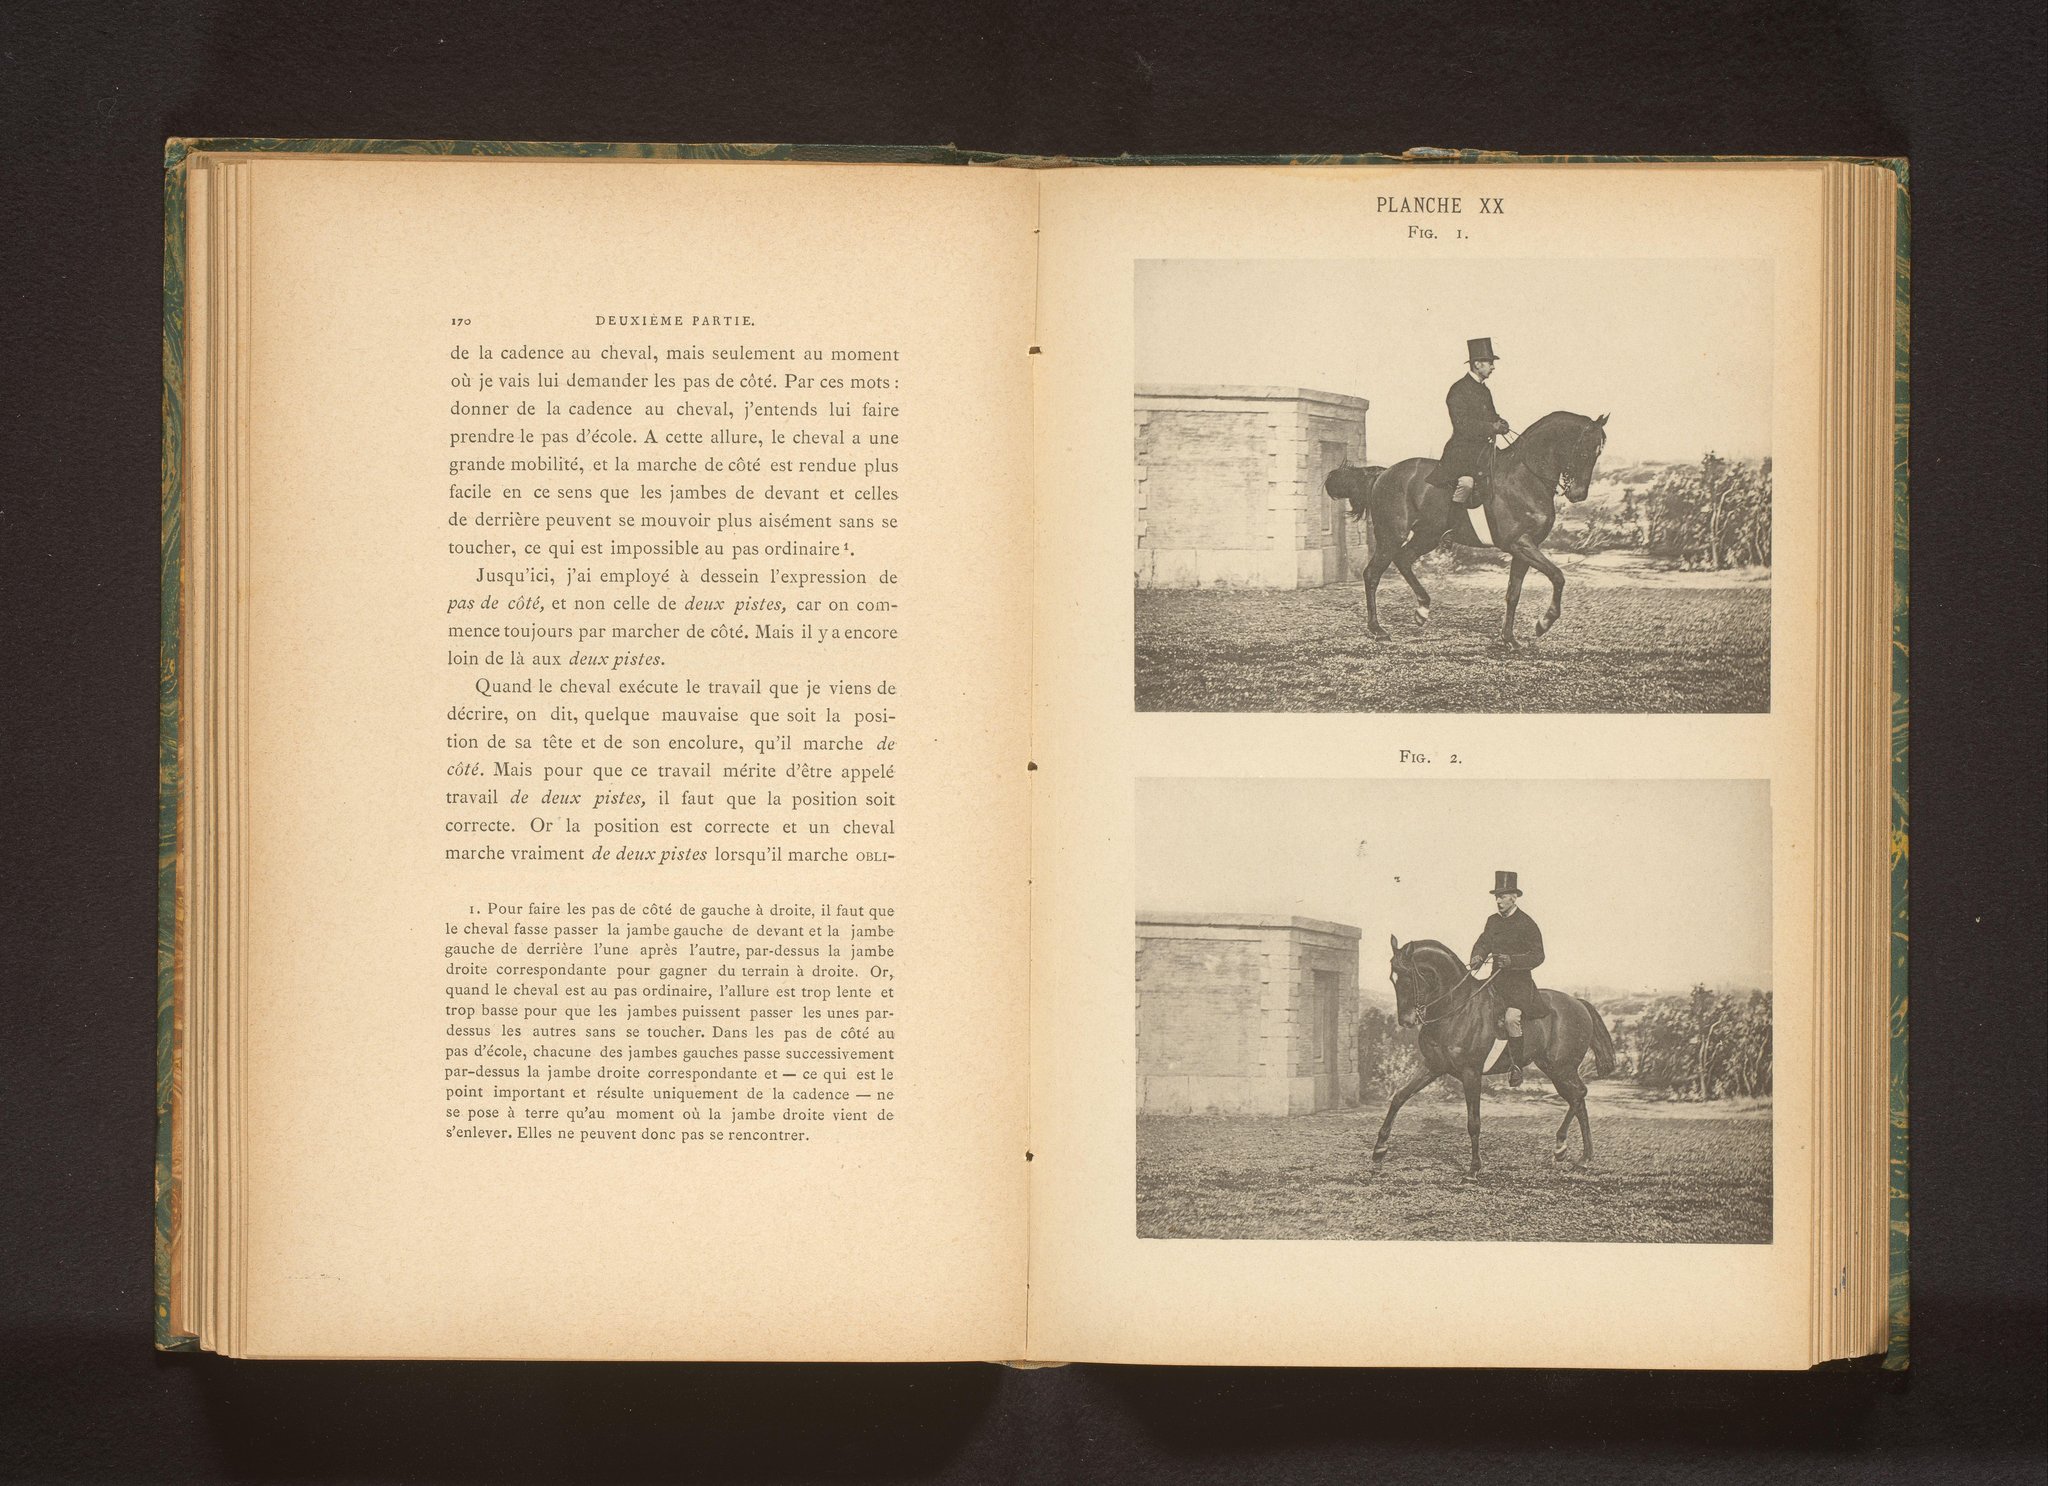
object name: photomechanical print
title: Twee mannen op paarden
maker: jean delton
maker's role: fotograaf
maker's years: 1850-1901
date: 1882-1892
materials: paper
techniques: photograph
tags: riding a horse, ass, or mule; rider, horseman, head-gear: top hat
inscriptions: number: ‘Planche XX Fig. 1. Fig. 2.’